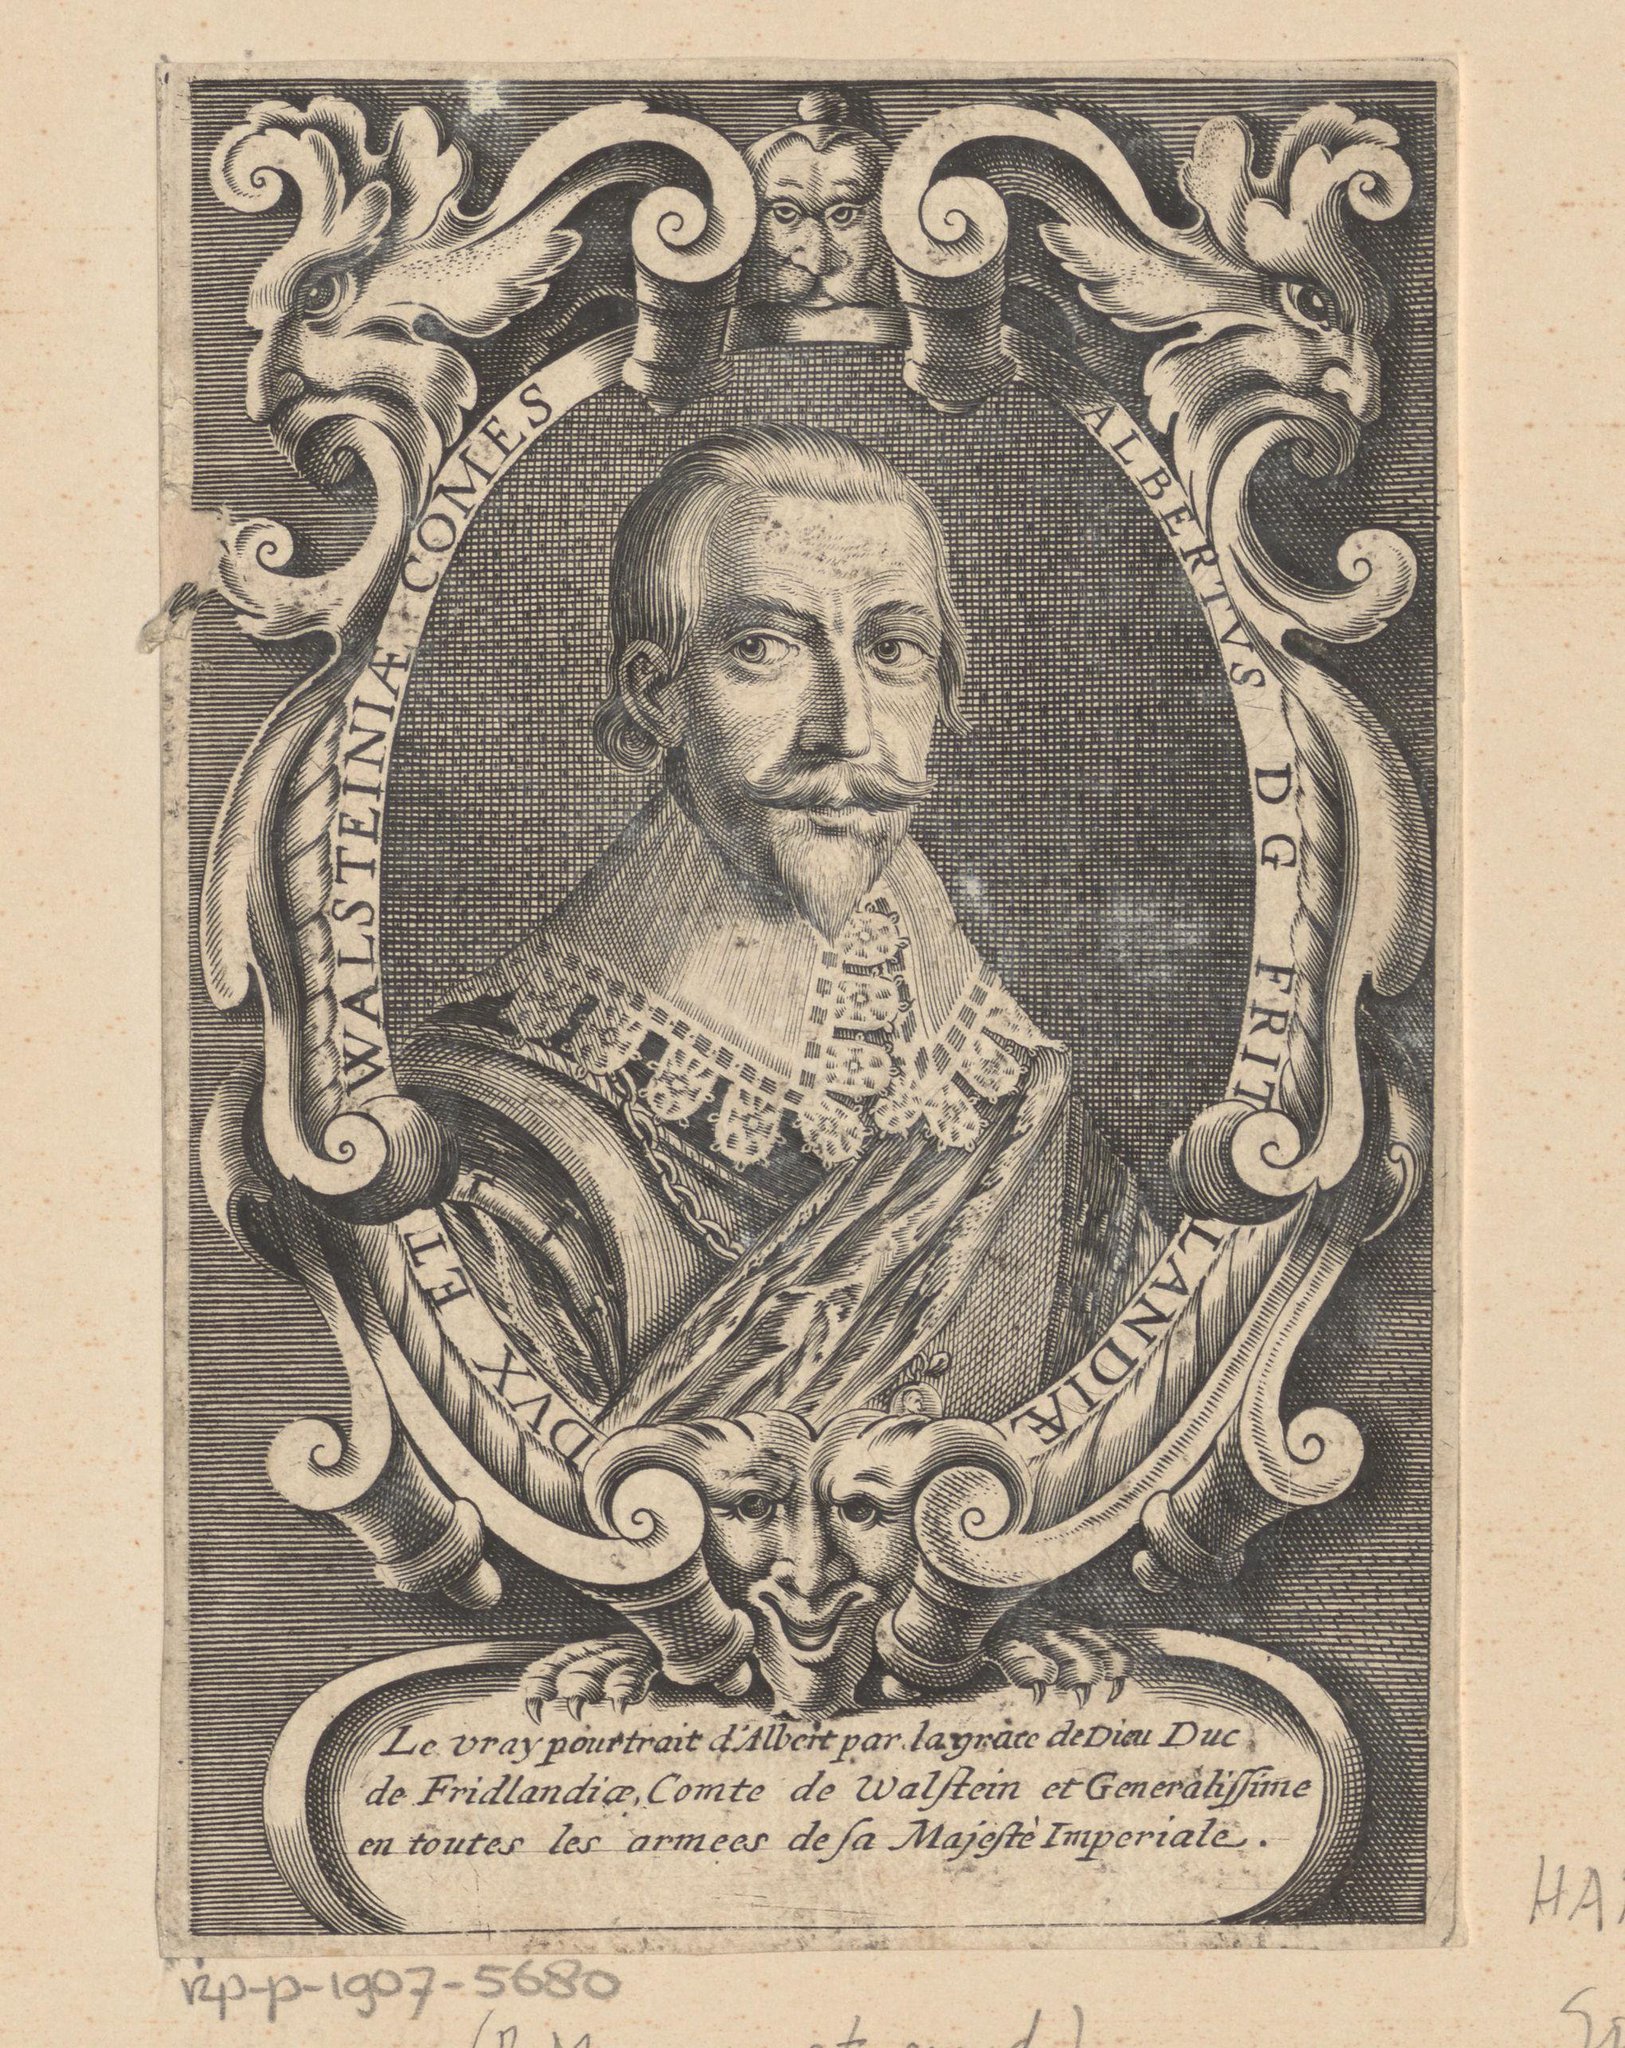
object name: print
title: Portret van Albrecht von Wallenstein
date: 1610-1668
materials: paper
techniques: engraving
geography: paris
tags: commander-in-chief, general, marshal, historical persons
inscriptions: collector's mark: Lugt 2228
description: Met een drieregelig onderschrift in het Frans.